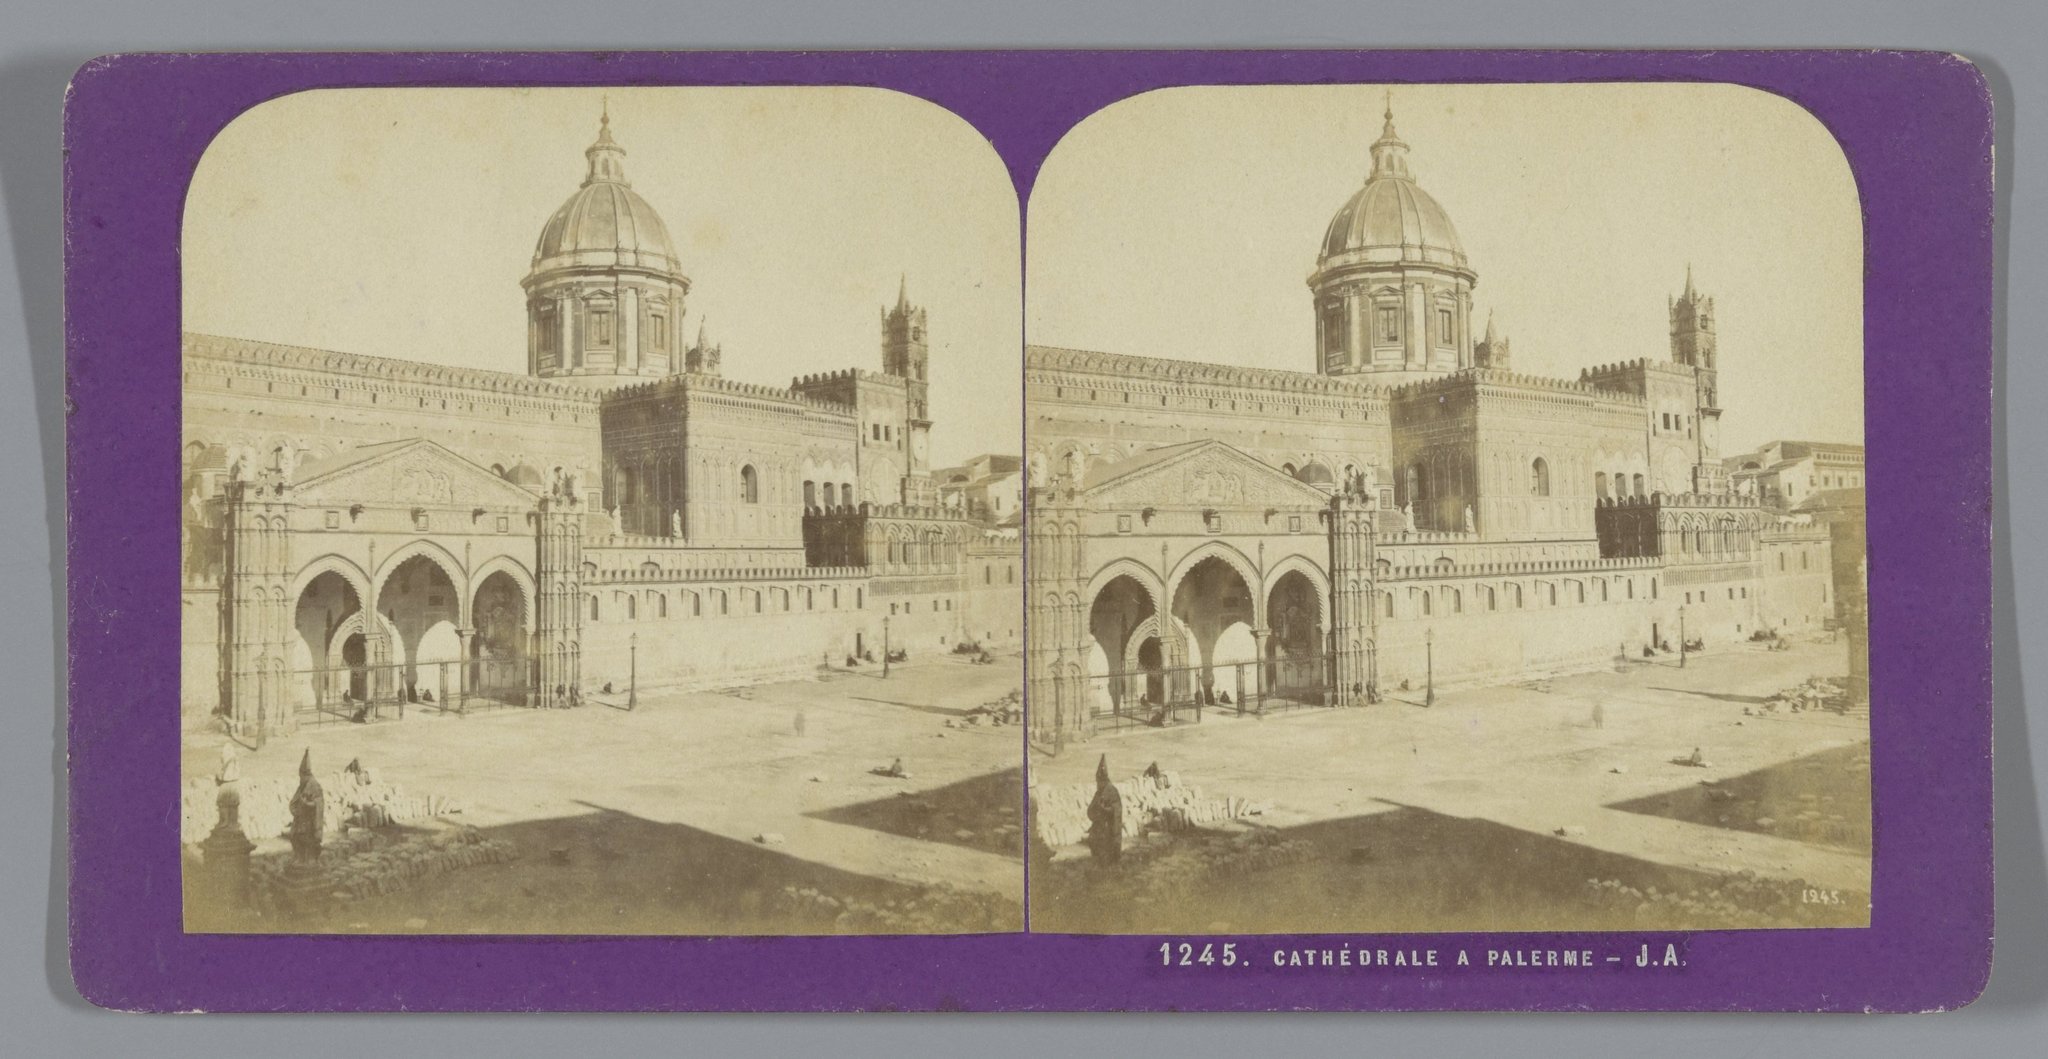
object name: stereograph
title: Gezicht op de Kathedraal van de Maria-Tenhemelopneming te Palermo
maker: jean andrieu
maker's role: fotograaf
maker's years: 1816-1872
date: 1862-1876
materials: cardboard, paper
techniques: albumen print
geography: palermo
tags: church (exterior)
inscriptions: number: ‘1245’